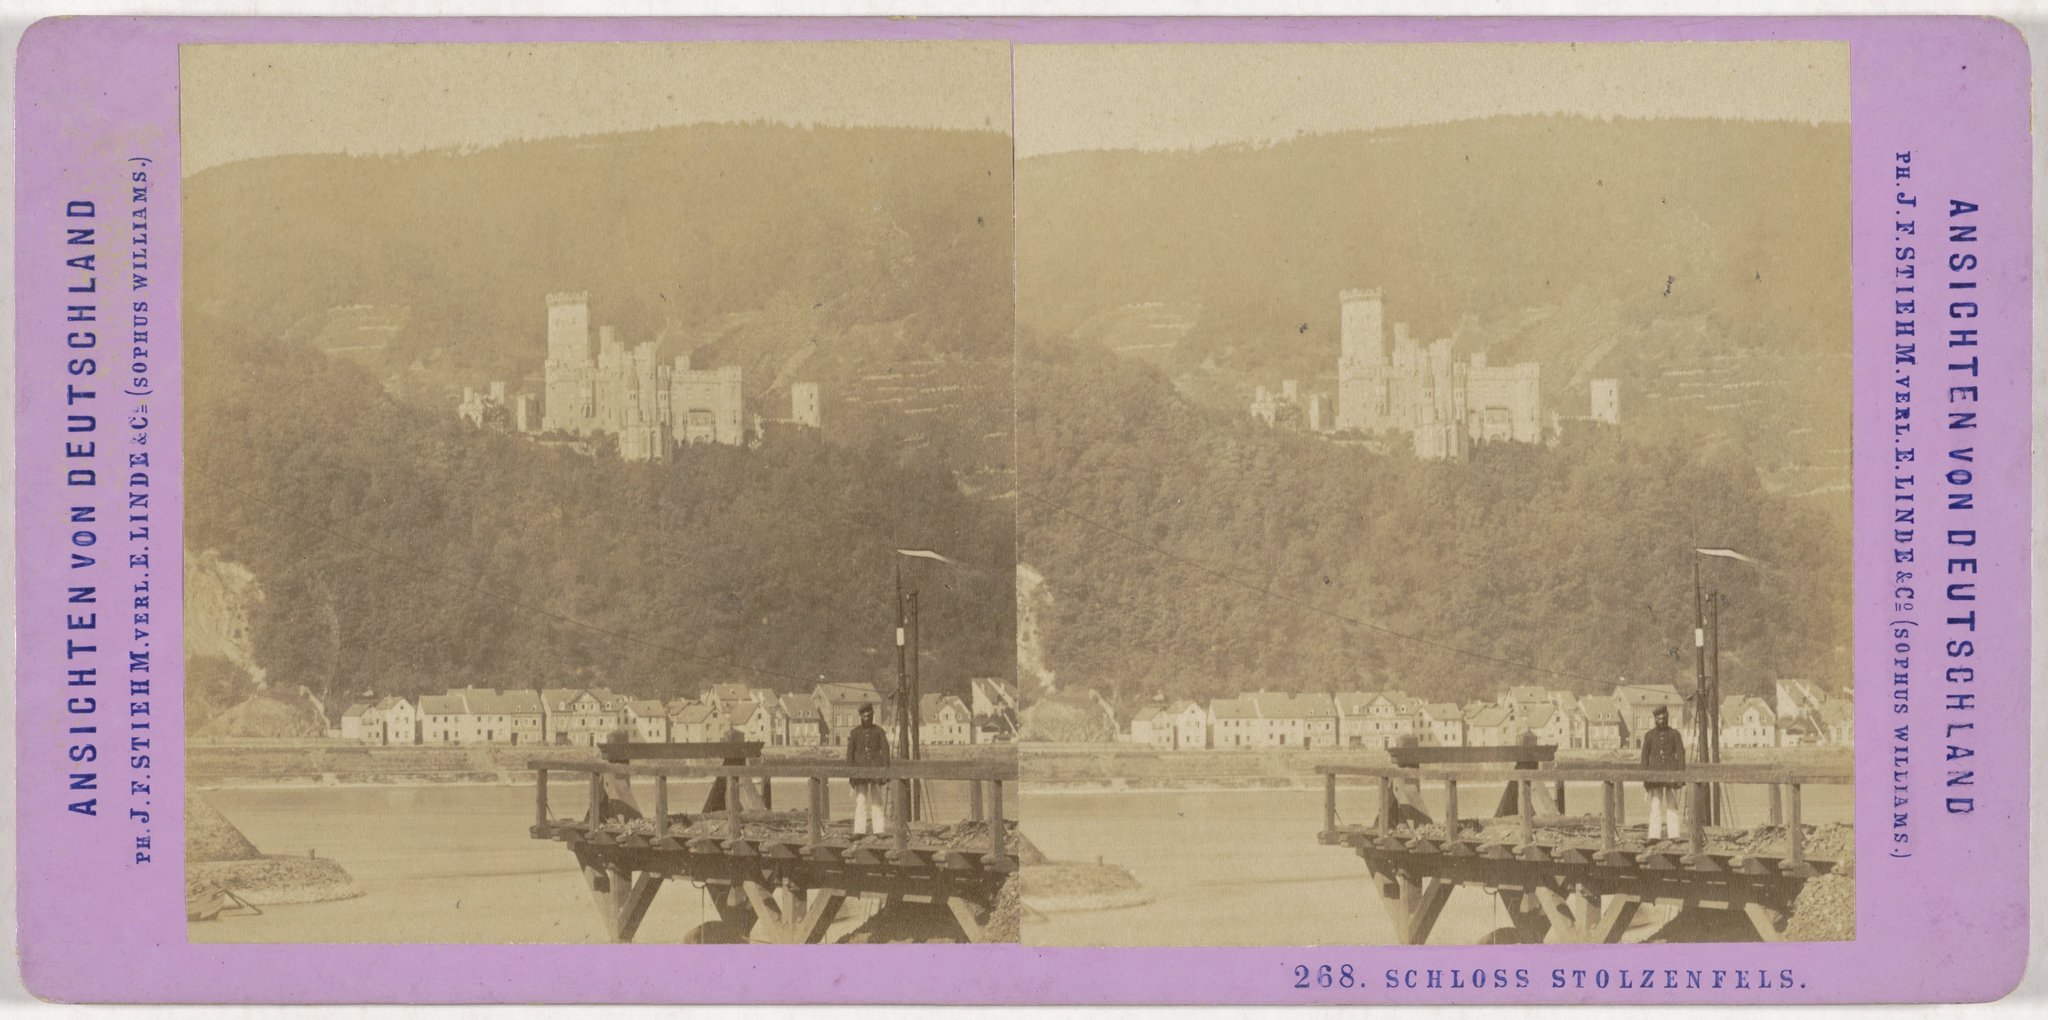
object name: stereograph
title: Ansichten von Deutschland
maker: johann friedrich stiehm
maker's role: fotograaf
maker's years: 1826-1902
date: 1869-1872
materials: cardboard, paper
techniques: albumen print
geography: koblenz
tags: prospect of village, silhouette of village, landscape with tower or castle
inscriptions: number: ‘268.’, inscription: ‘44’